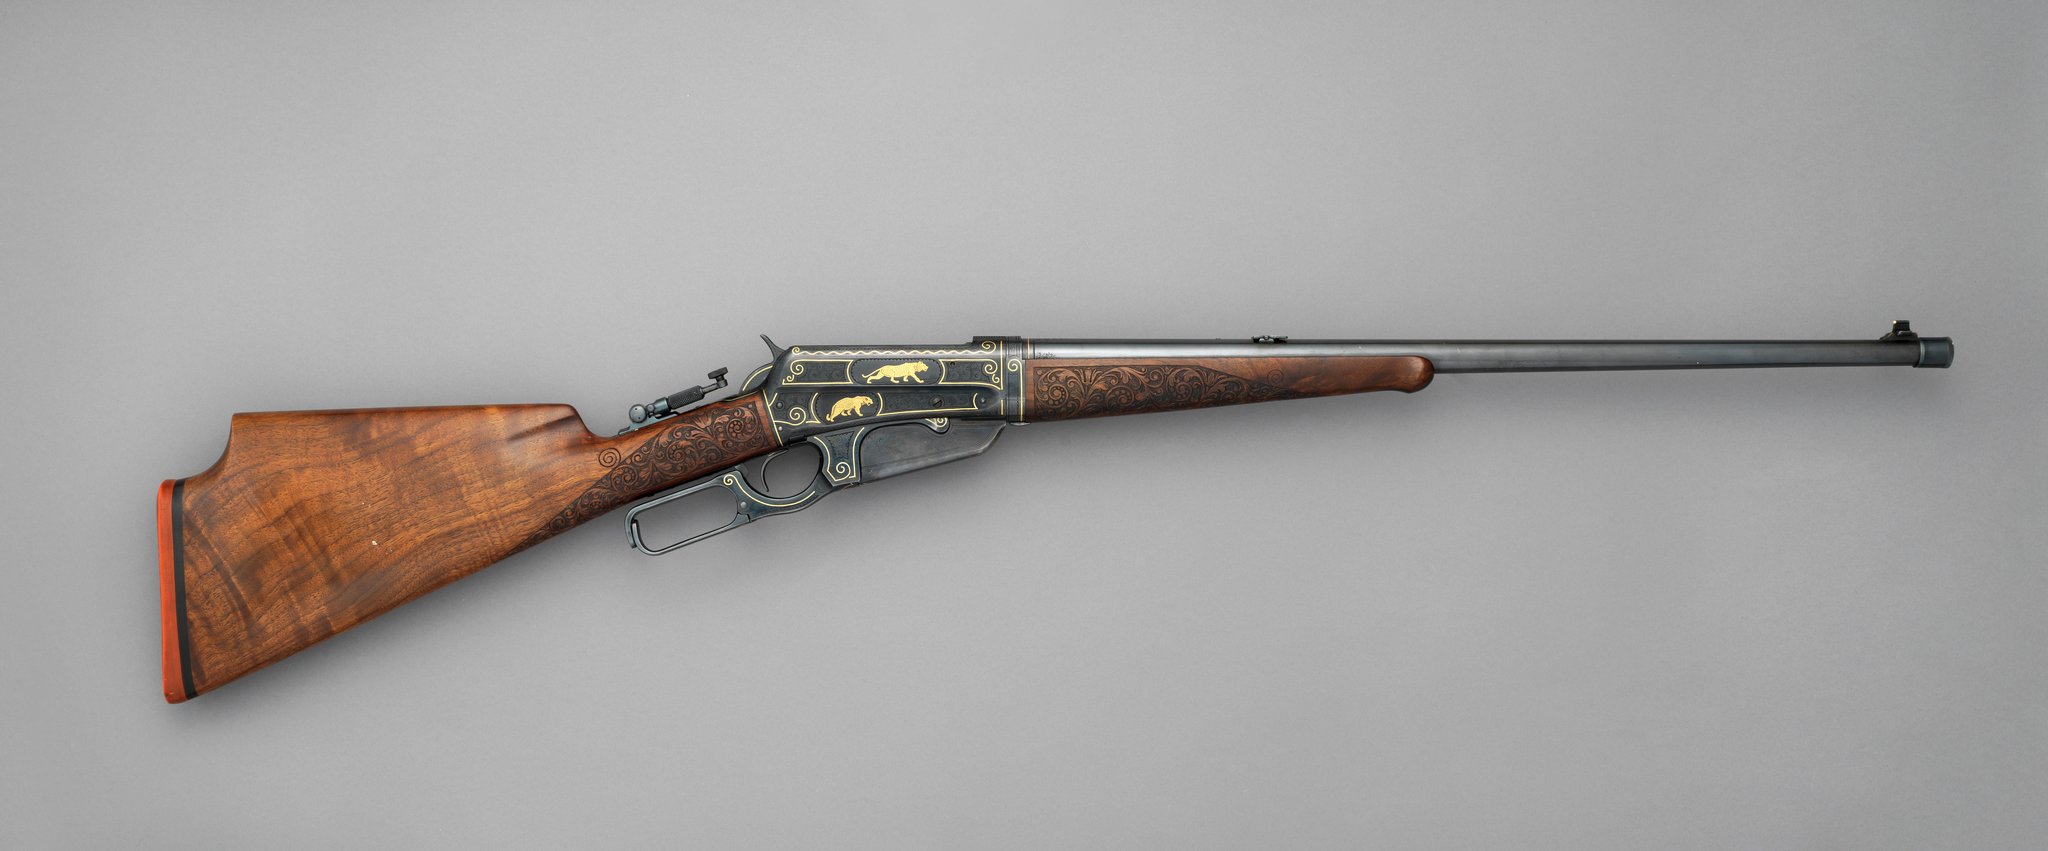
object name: rifle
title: Winchester Model 1895 Takedown Rifle (serial no. 81851)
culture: american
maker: winchester repeating arms company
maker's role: manufacturer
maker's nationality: american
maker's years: 1866-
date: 1913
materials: gold, platinum, steel, wood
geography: united states